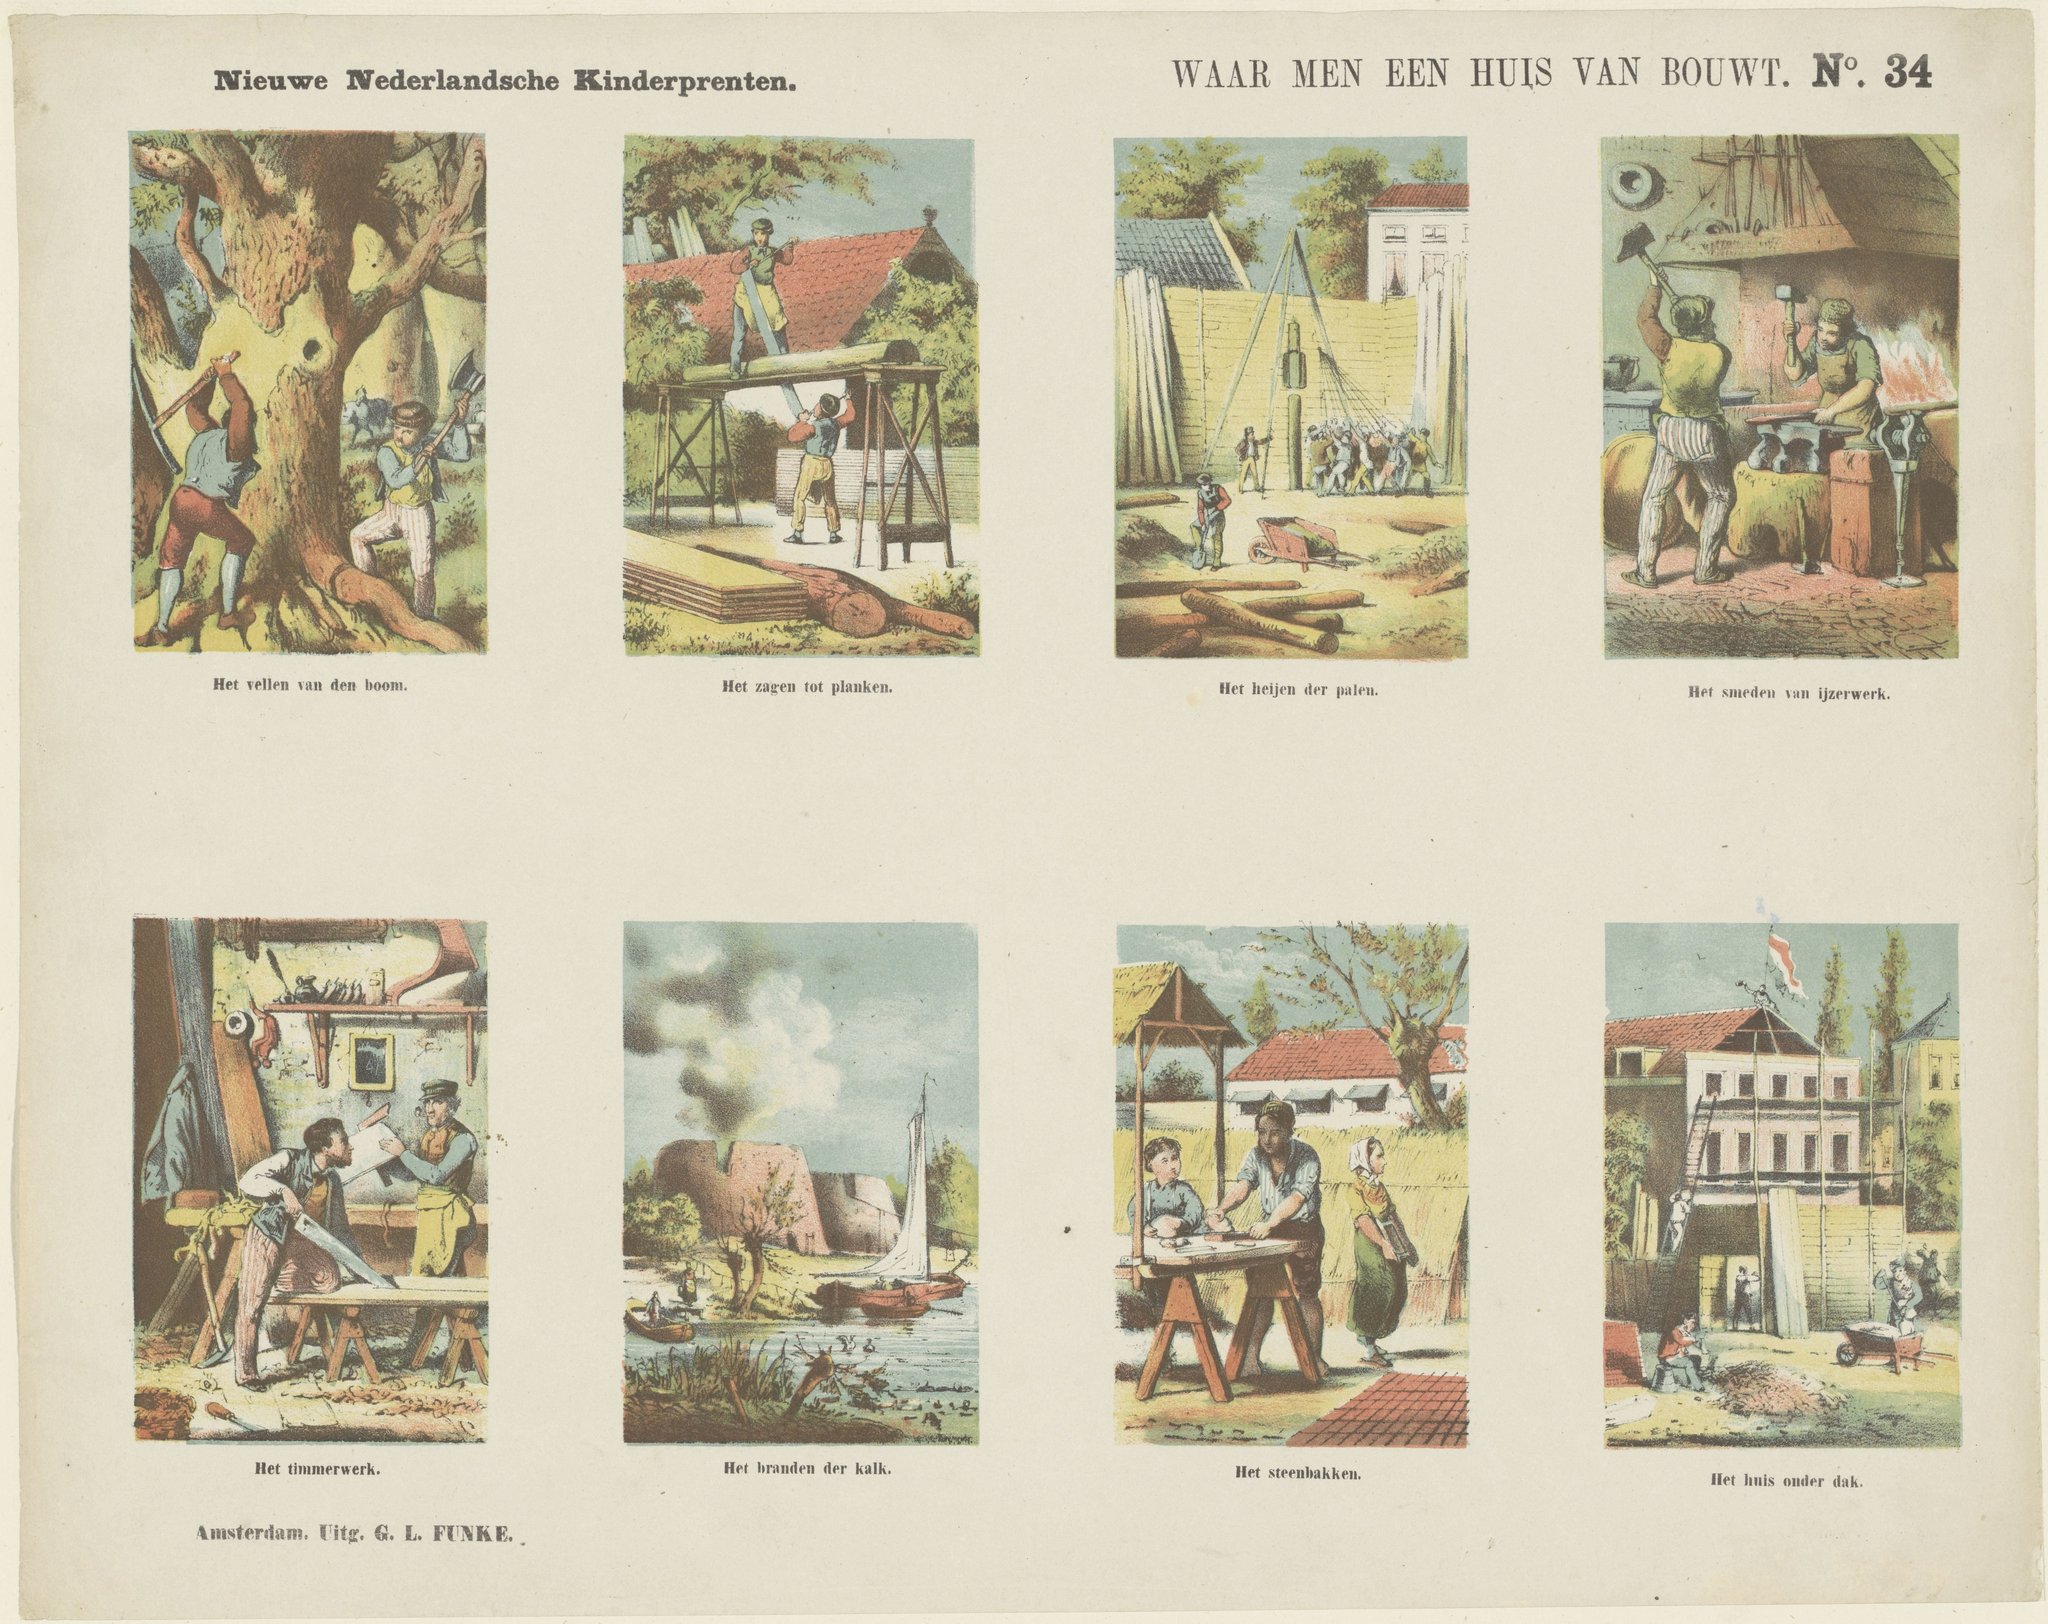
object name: print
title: Waar men een huis van bouwt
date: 1865-1875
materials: paper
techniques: lithograph, letterpress printing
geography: haarlem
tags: roof (of house or building), building-site, sawing (industrial process)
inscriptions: collector's mark: Lugt 2760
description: Blad met 8 voorstellingen over het bouwen van een huis. Van het kappen van bomen tot aan het plaatsen van het dak. Onder elke afbeelding een onderschrift. Genummerd rechtsboven: No. 34.